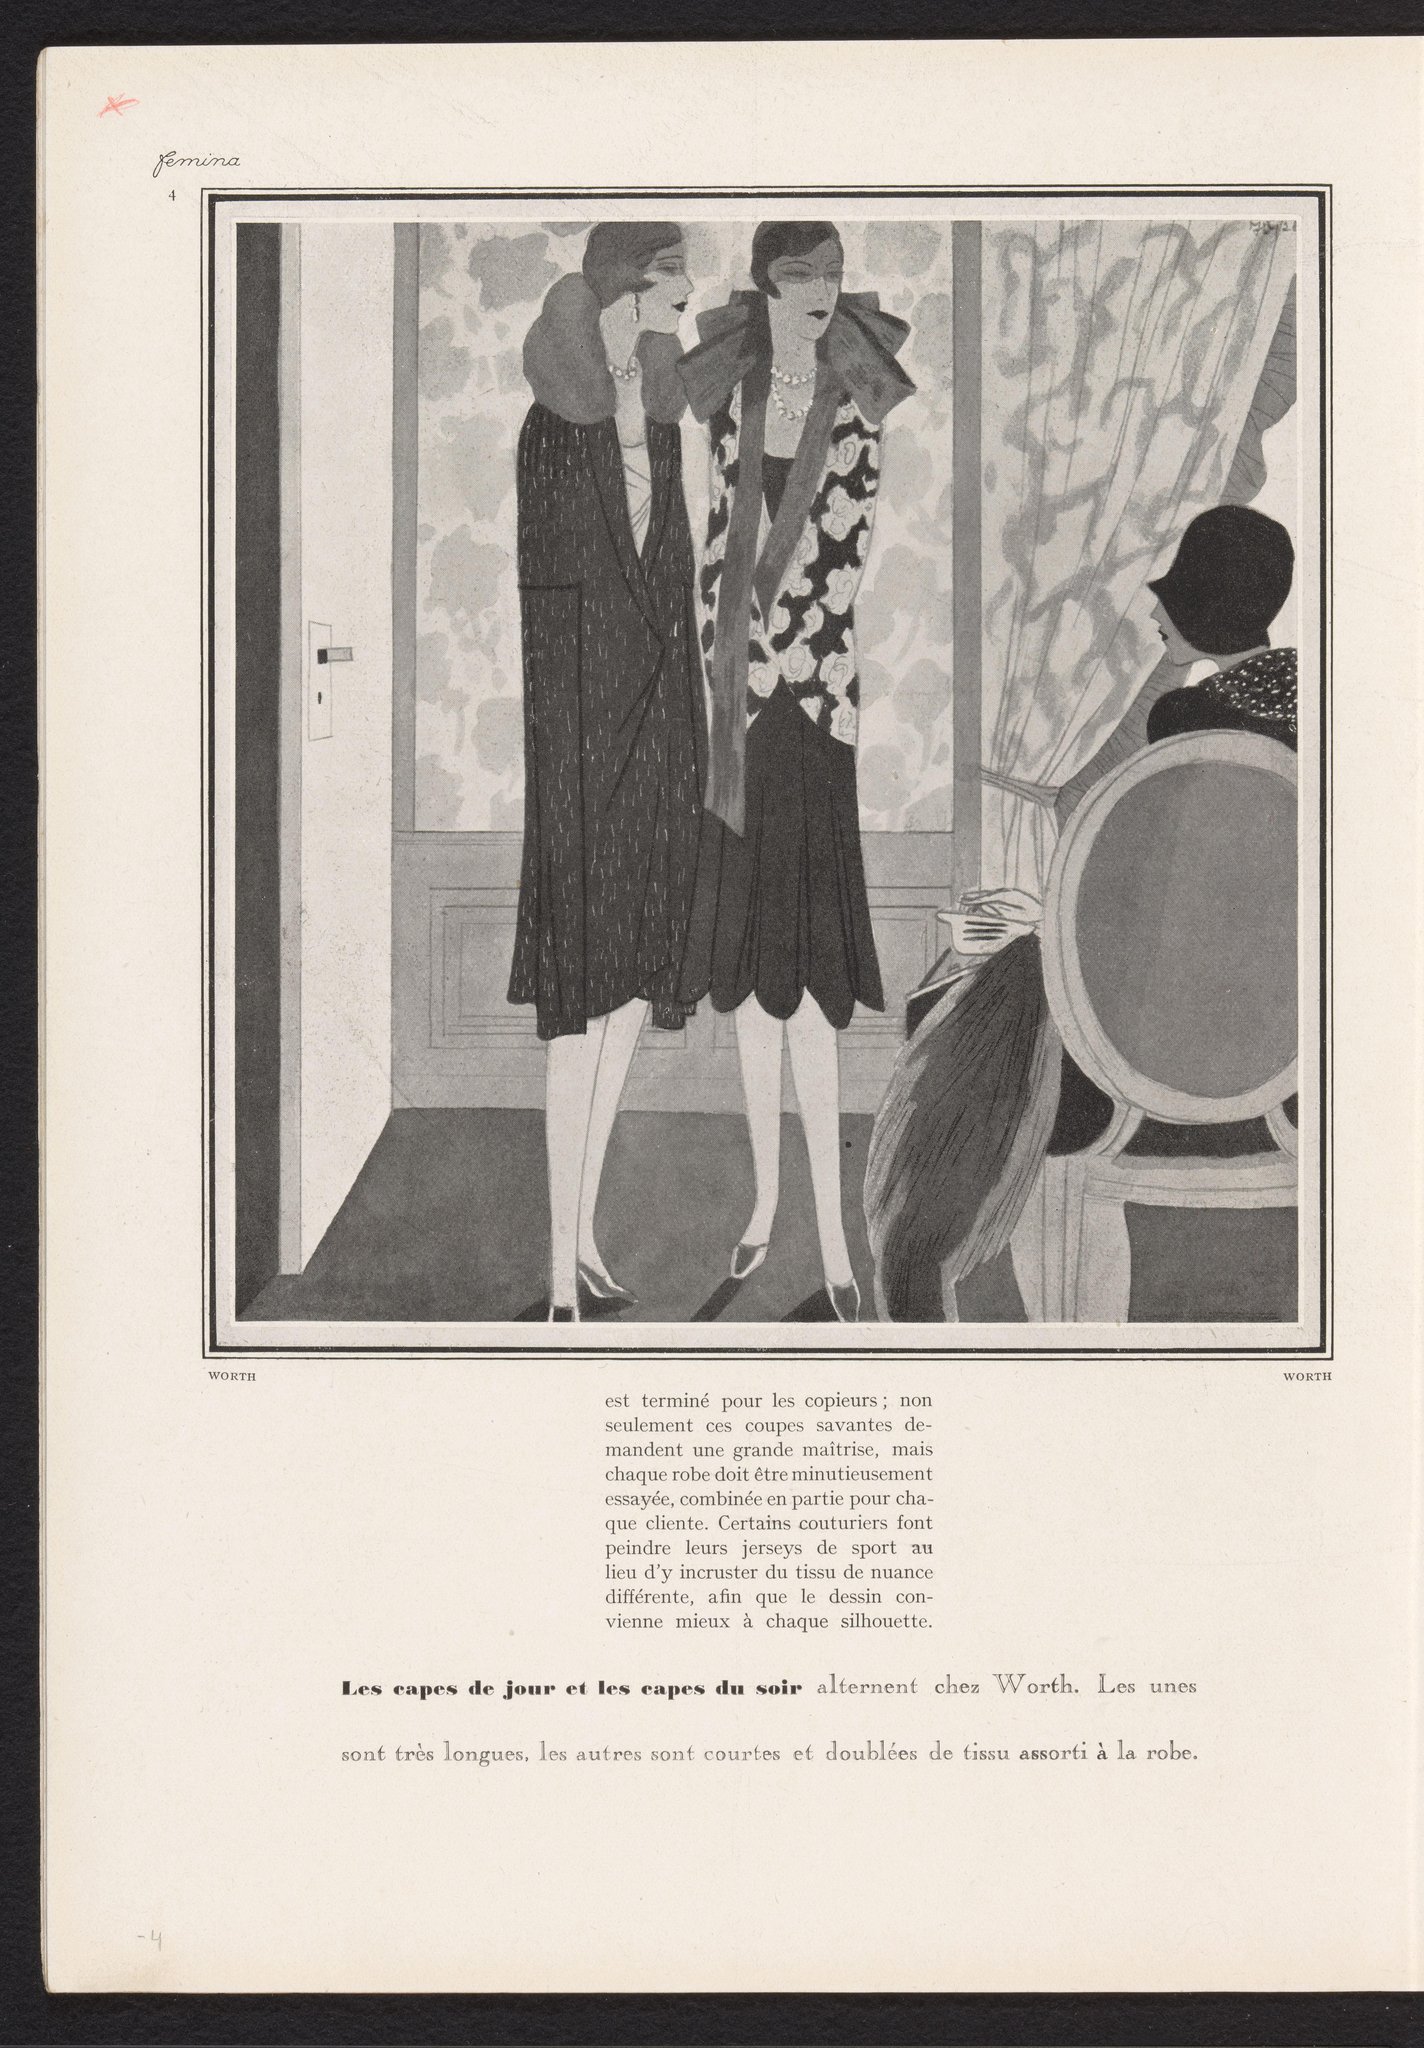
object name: fashion print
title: Femina, Mars 1928: 4: Les capes de jour e les capes du soir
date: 1928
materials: paper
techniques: photography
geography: paris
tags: fashion plates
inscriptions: title: ‘FEMINA Un regard indiscrèt sur les modes de printemps’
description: Modetijdschrift Femina. Mars 1928, 4: Korte cape voor overdag en lange avondcape van Worth